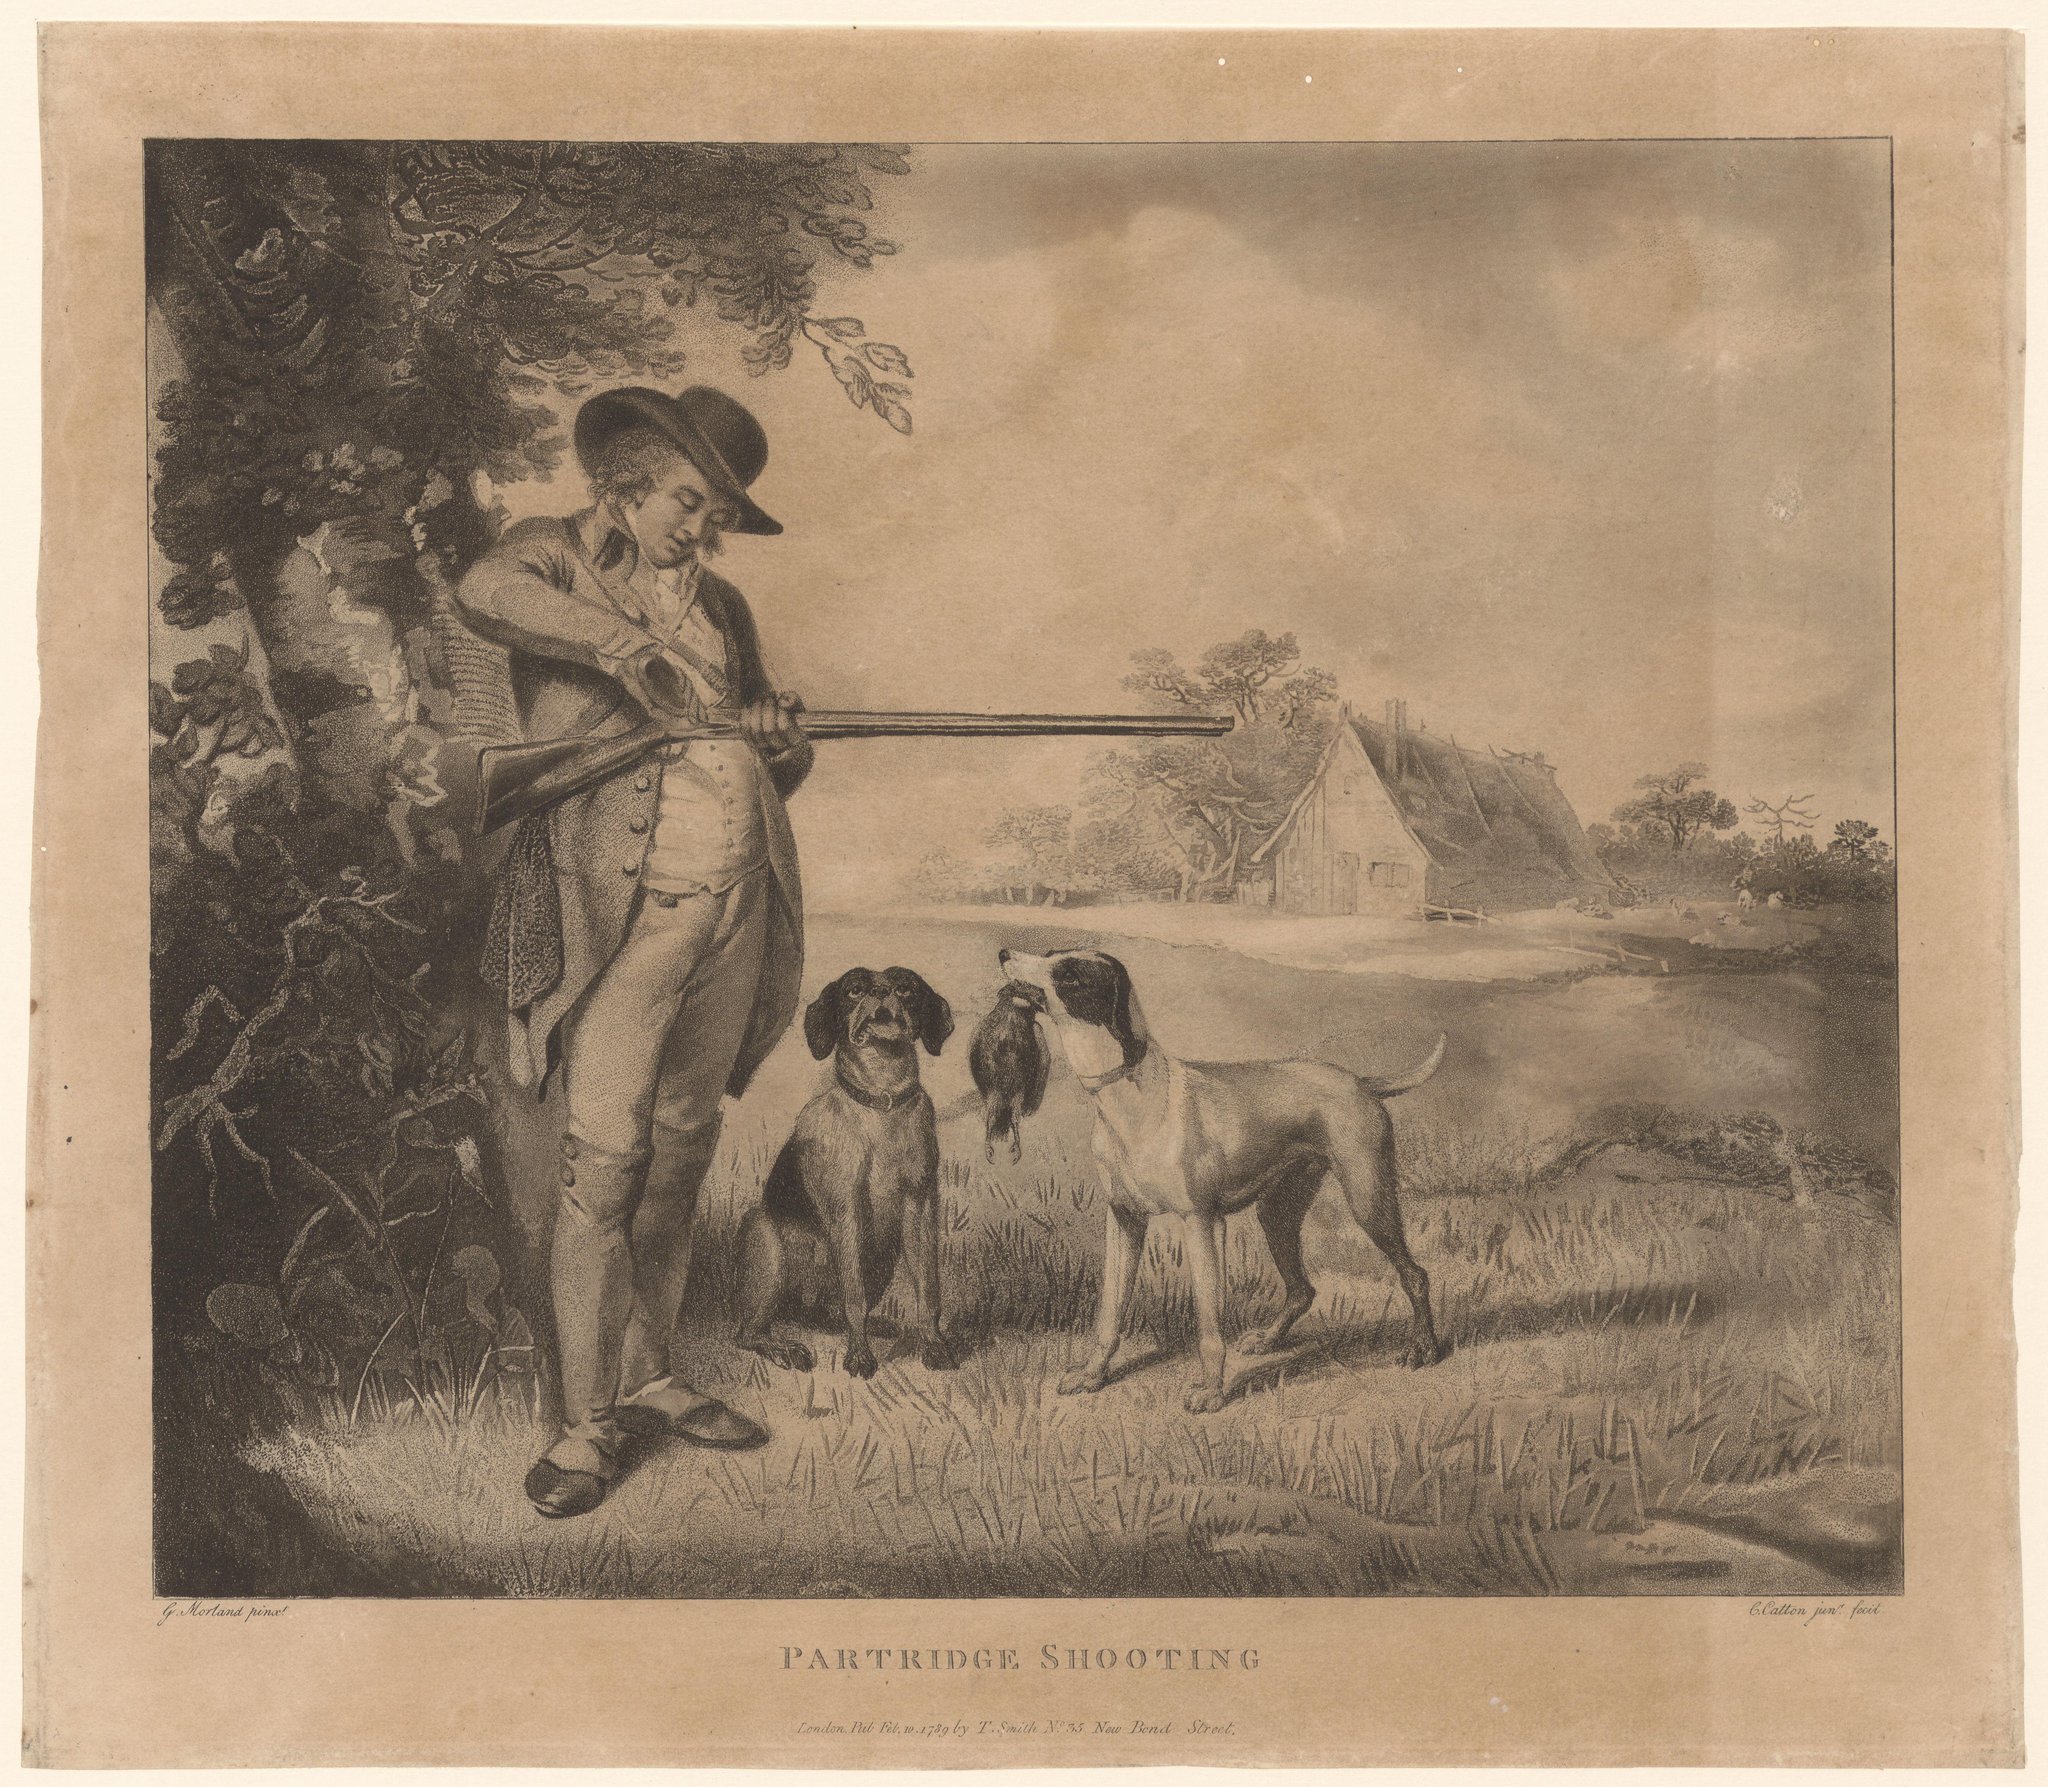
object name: print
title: Partridge Shooting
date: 1789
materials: paper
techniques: aquatint, etching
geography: london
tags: hunting dogs, walker and runner birds: partridge, bird hunting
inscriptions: collector's mark: Lugt 2228